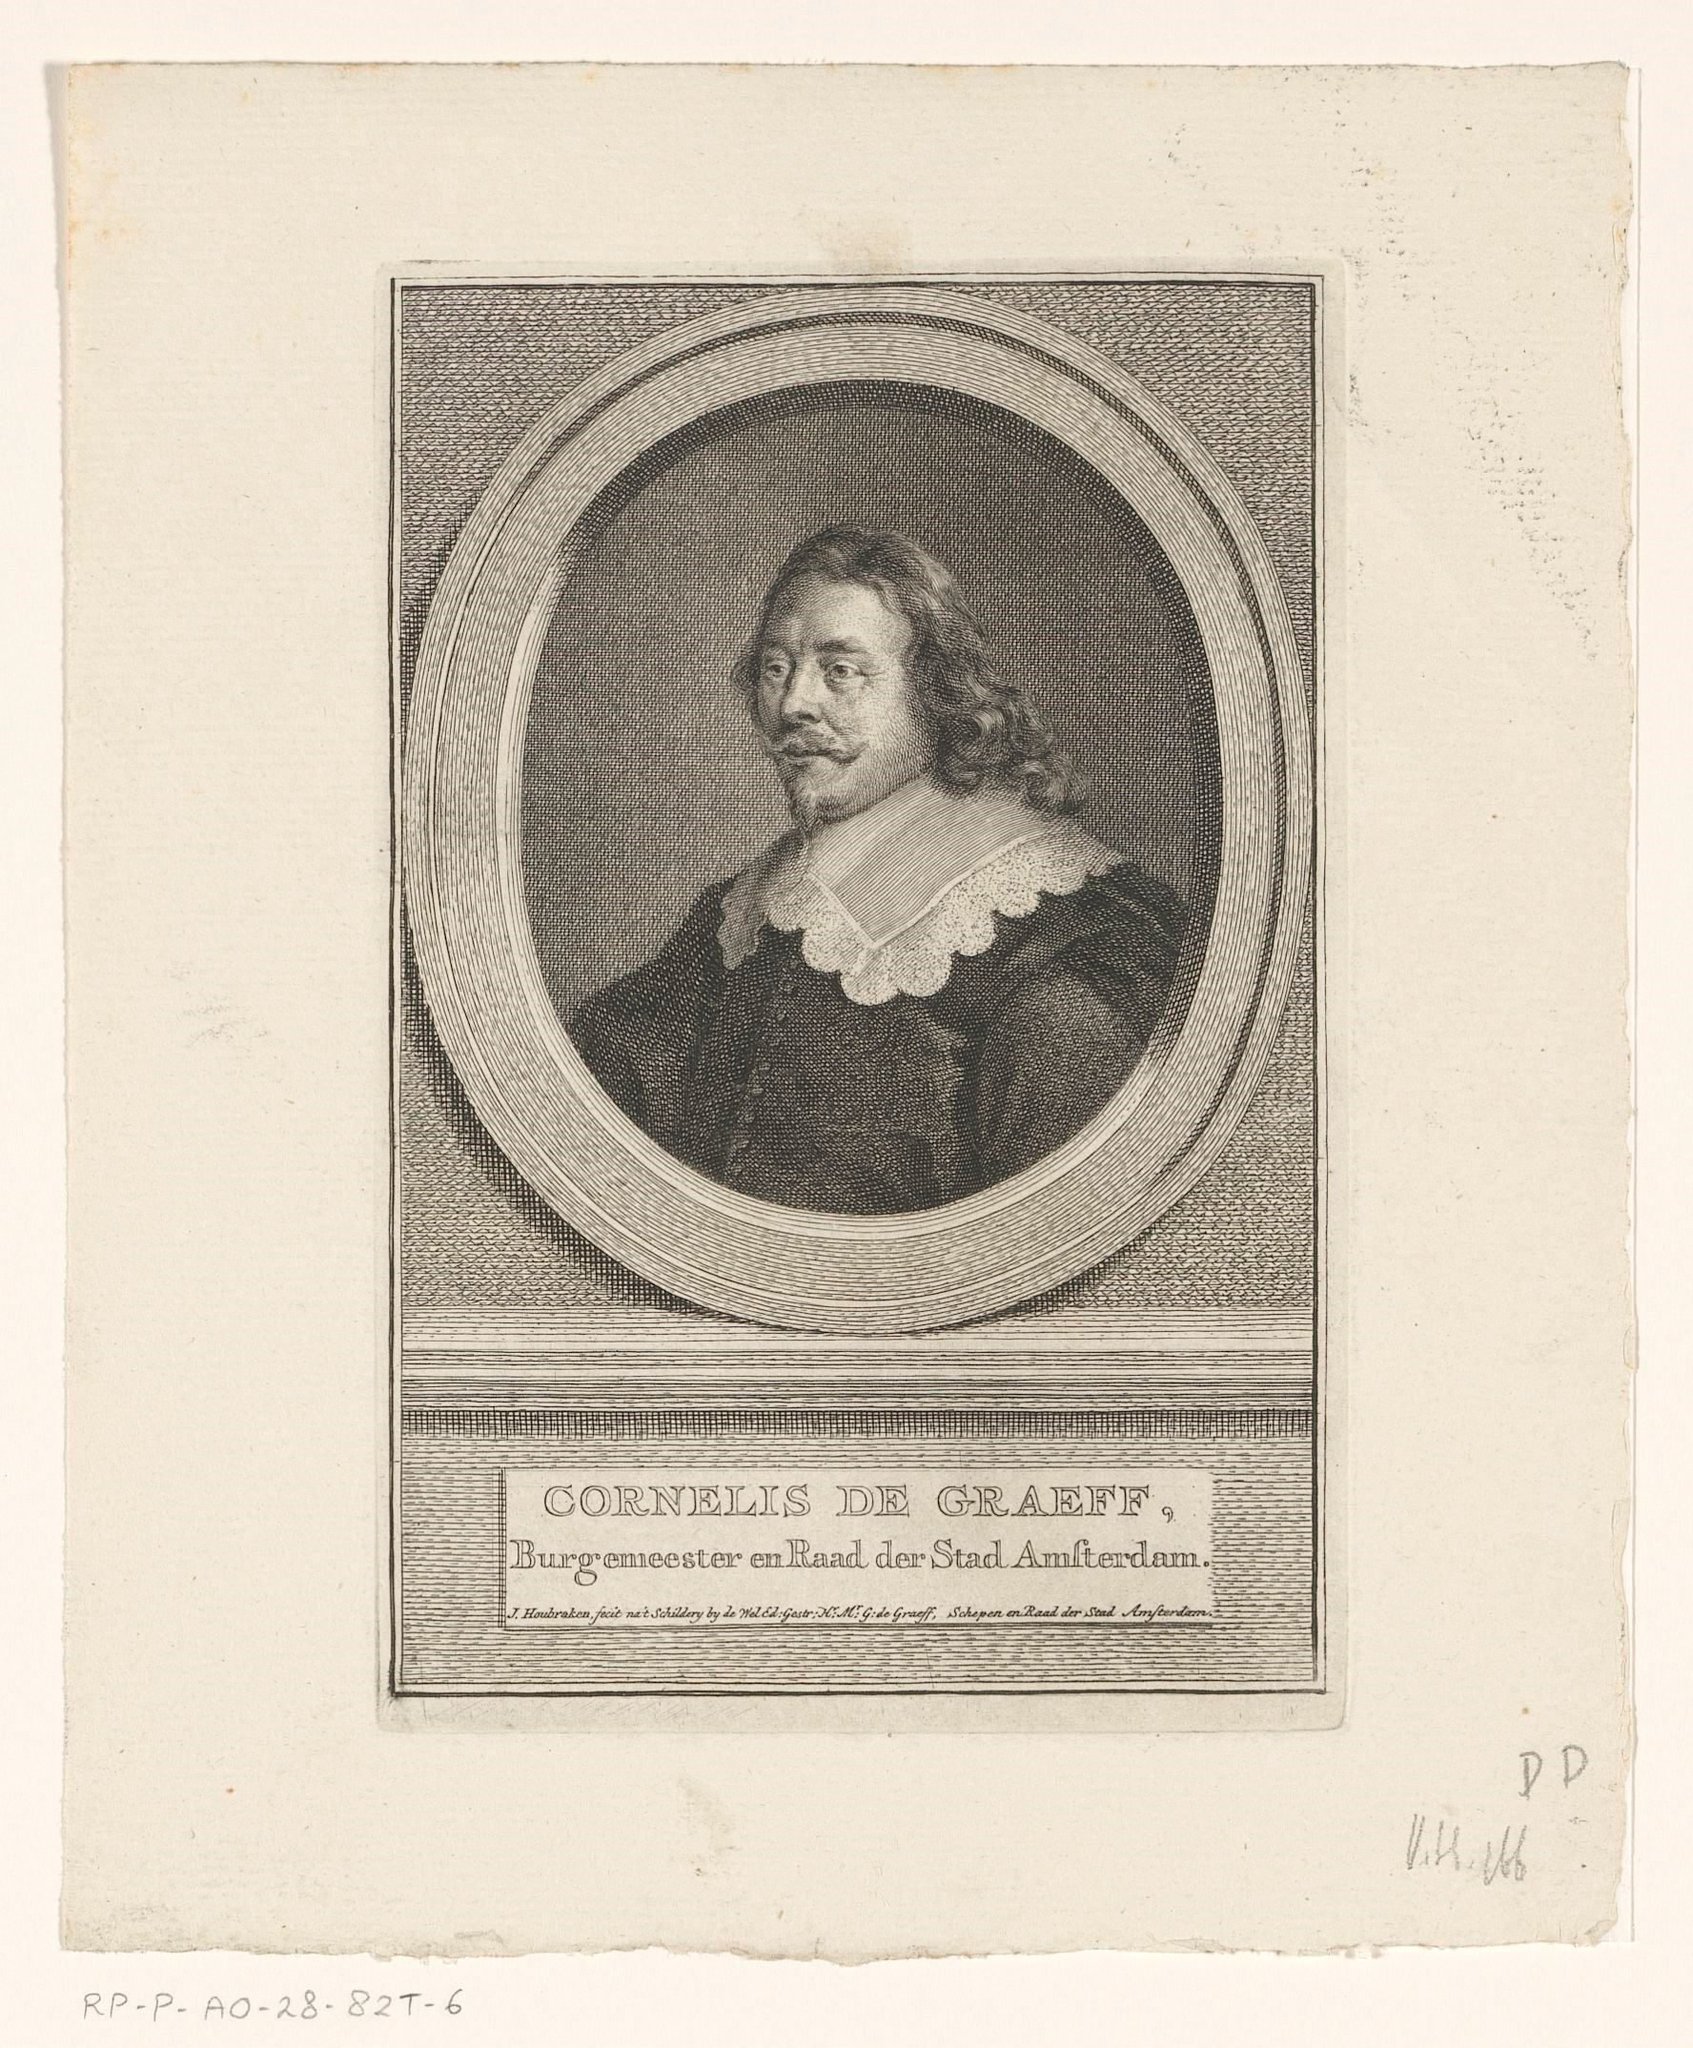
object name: print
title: Portret van Cornelis de Graeff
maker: jacob houbraken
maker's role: draughtsman, print maker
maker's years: 1698-1780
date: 1749-1780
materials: paper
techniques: engraving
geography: amsterdam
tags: mayor, cornelis de graeff, historical persons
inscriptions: collector's mark: Lugt 2228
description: Deze prent is oorspronkelijk bedoeld als aanvulling op Jan Wagenaars ‘Vaderlandsche historie’* en was zo vanaf 1796 verkrijgbaar bij Johannes Allart te Amsterdam. Voor de advertentie waarin Allart de 60 portretten en 7 platen, allen gegraveerd door Houbraken, ter aanvulling op Wagenaars ‘Vaderlandsche historie’ aanbiedt, zie RP-P-OB-77.766. *Van dit werk zijn in de achttiende eeuw meerdere uitgaves verschenen, zoals: Wagenaar, Jan. Vaderlandsche historie, vervattende de geschiedenissen der Vereenigde Nederlanden (…). 21 delen. Amsterdam: Isaak Tirion, 1749-1759. Wagenaar, Jan. Vaderlandsche historie, vervattende de geschiedenissen der nu Vereenigde Nederlanden (…). 21 delen. Amsterdam: weduwe Isaak Tirion, 1770. Wagenaar, Jan. Vaderlandsche historie, vervattende de geschiedenissen der nu Vereenigde Nederlanden (…). 21 delen. Amsterdam, Leiden, Dordrecht en Harlingen: P. Schouten e.a., 1782. Wagenaar, Jan. Vaderlandsche historie, vervattende de geschiedenissen der nu Vereenigde Nederlanden (…). 21 delen. Amsterdam: Johannes Allart, 1790-1796.